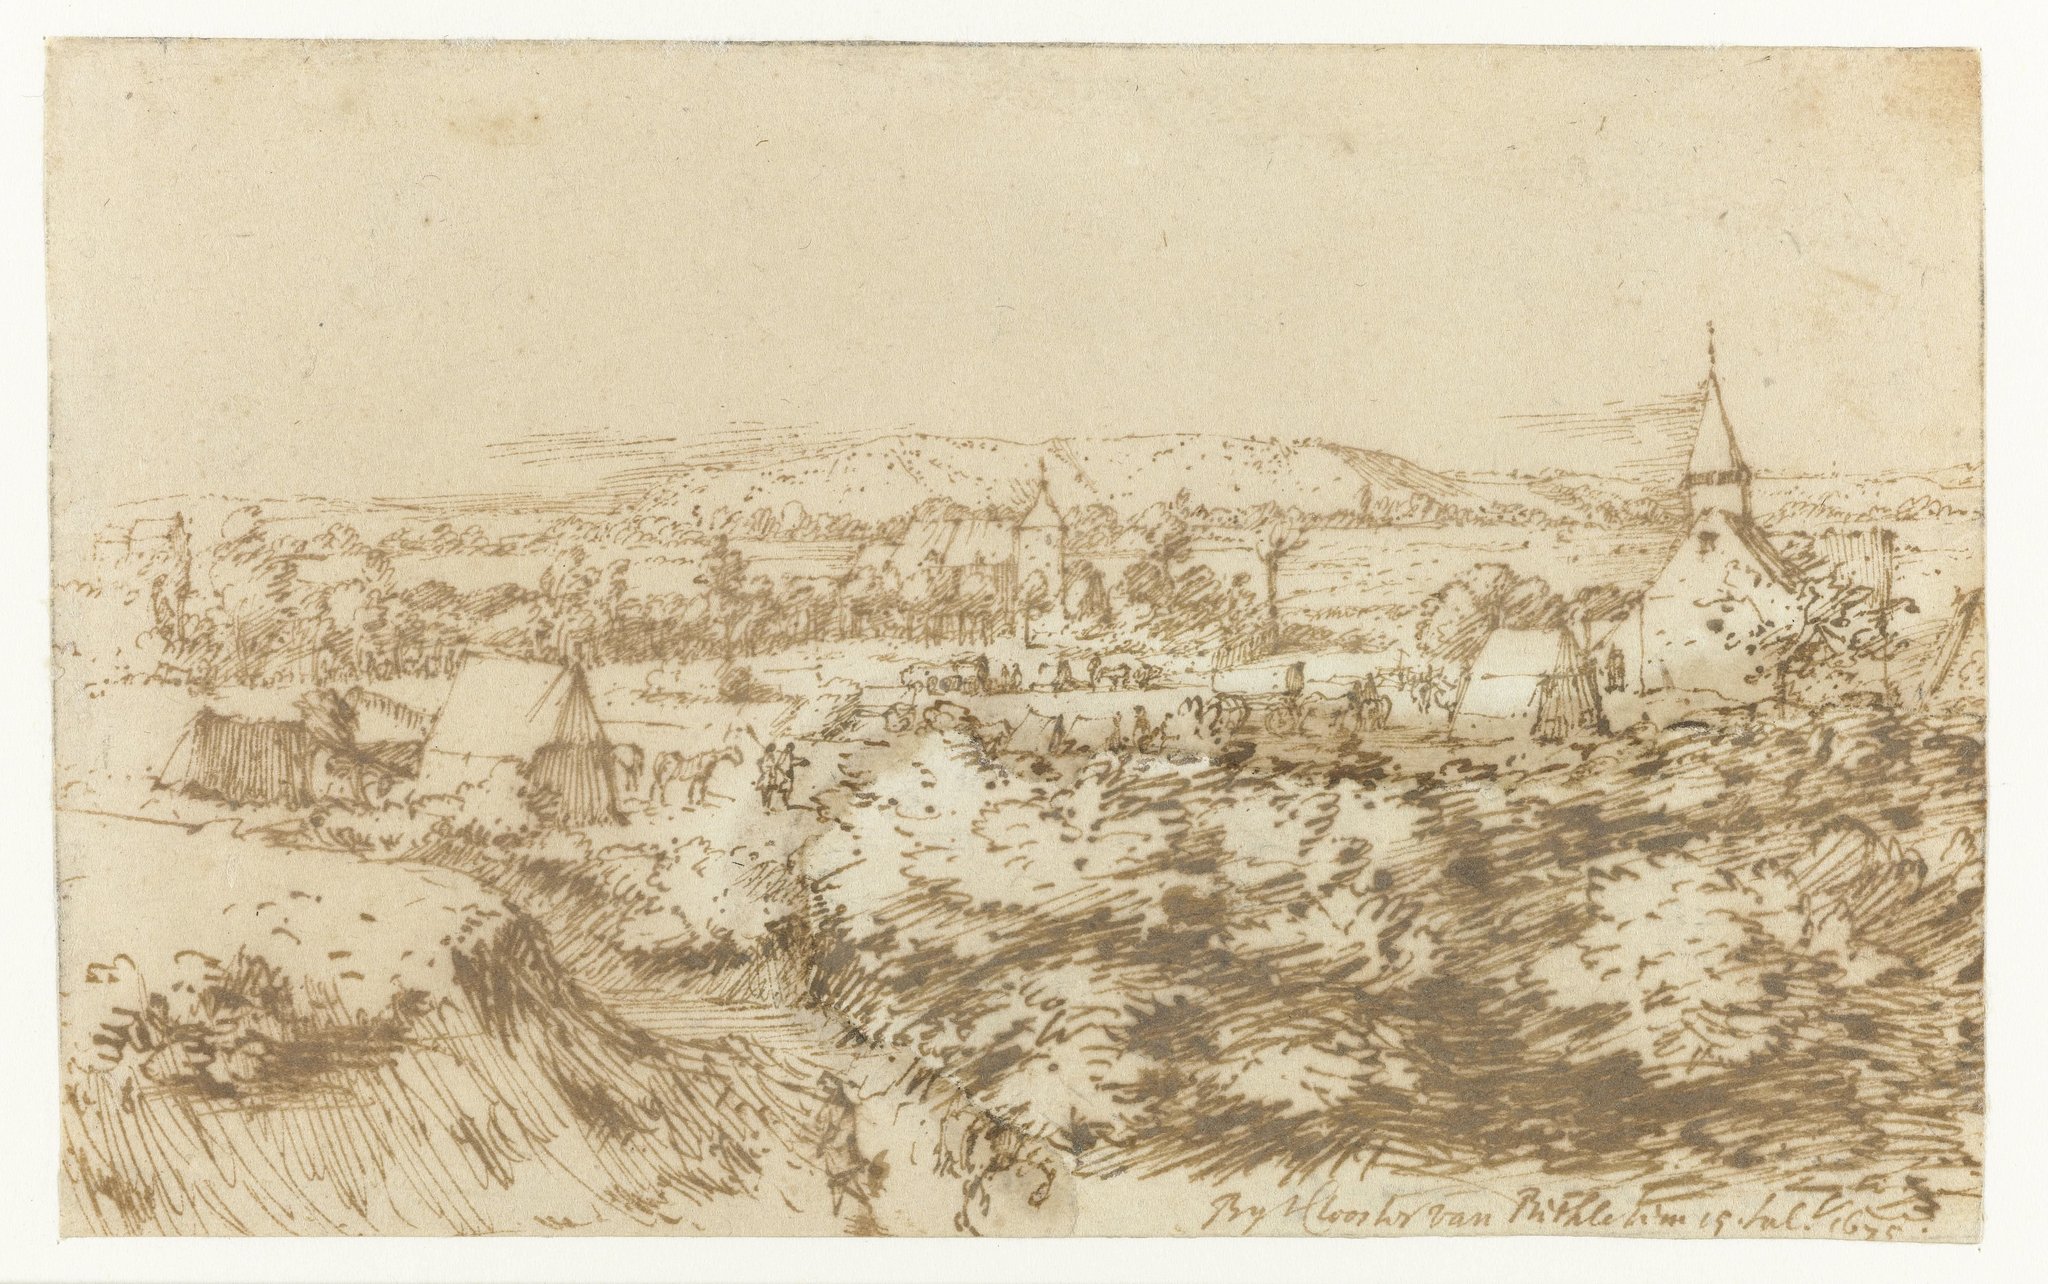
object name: drawing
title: Gezicht op legerplaats bij het Klooster Bethlehem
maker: constantijn huygens (ii)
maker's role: draughtsman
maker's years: 1628-1697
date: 1675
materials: ink, paper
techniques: pen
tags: city-view, and landscape with man-made constructions, (military) camp with tents